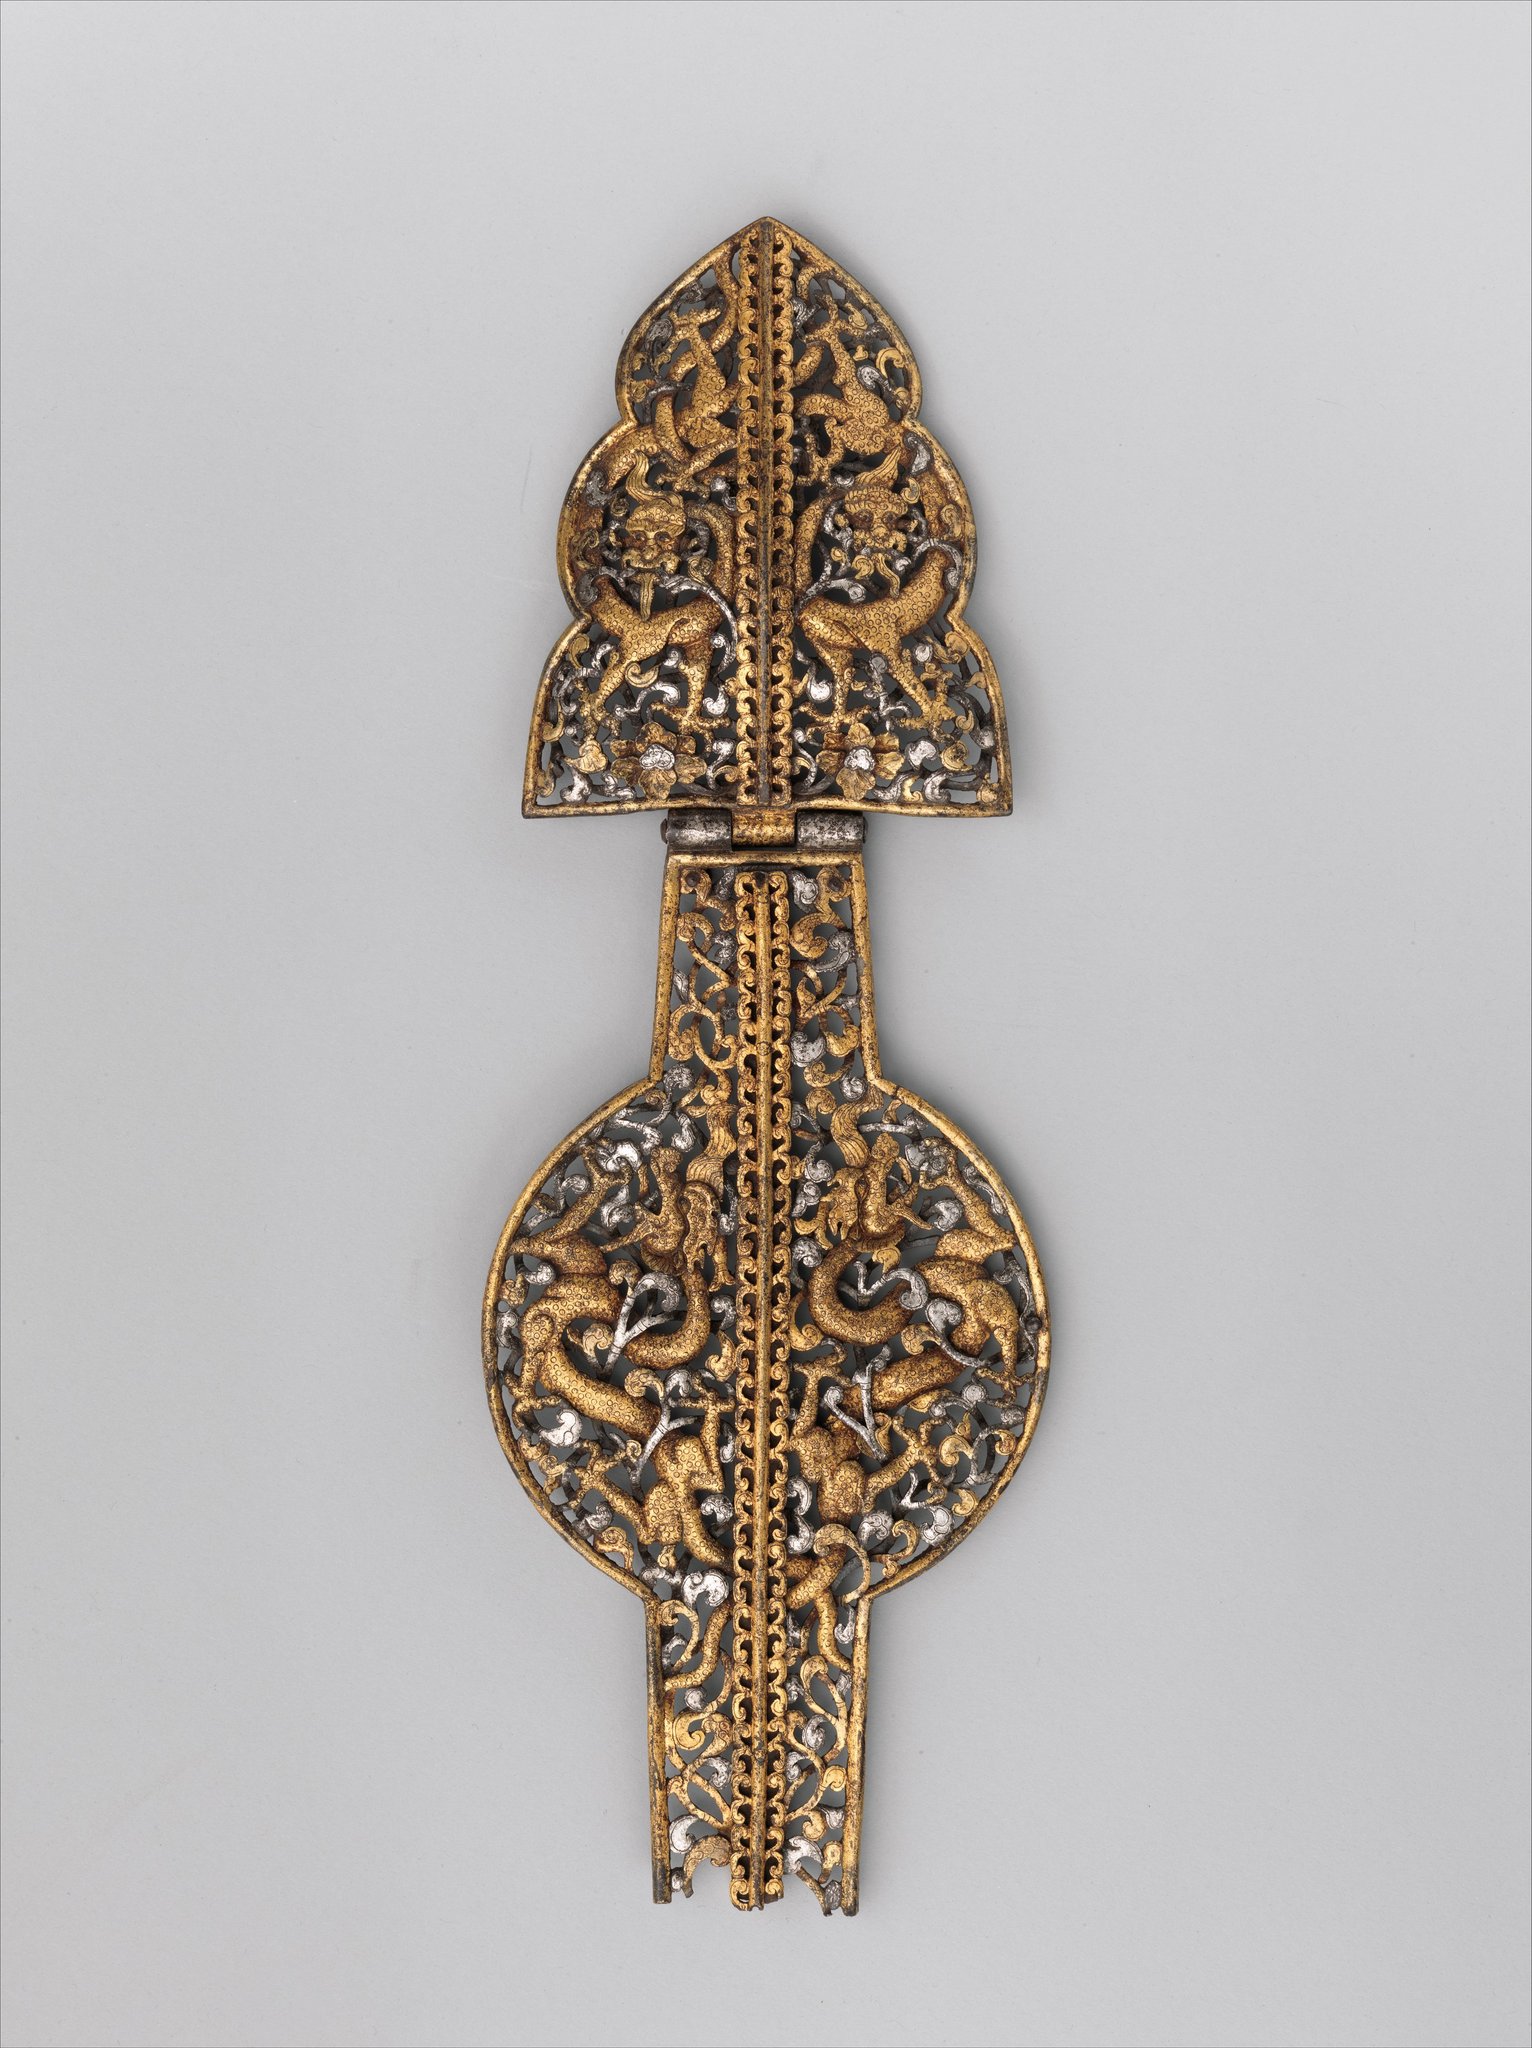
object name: frontal plate from a shaffron horse's head defense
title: Frontal Plate from a Shaffron (Horse's Head Defense)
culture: tibetan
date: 1501-1700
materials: gold, iron, silver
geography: tibet